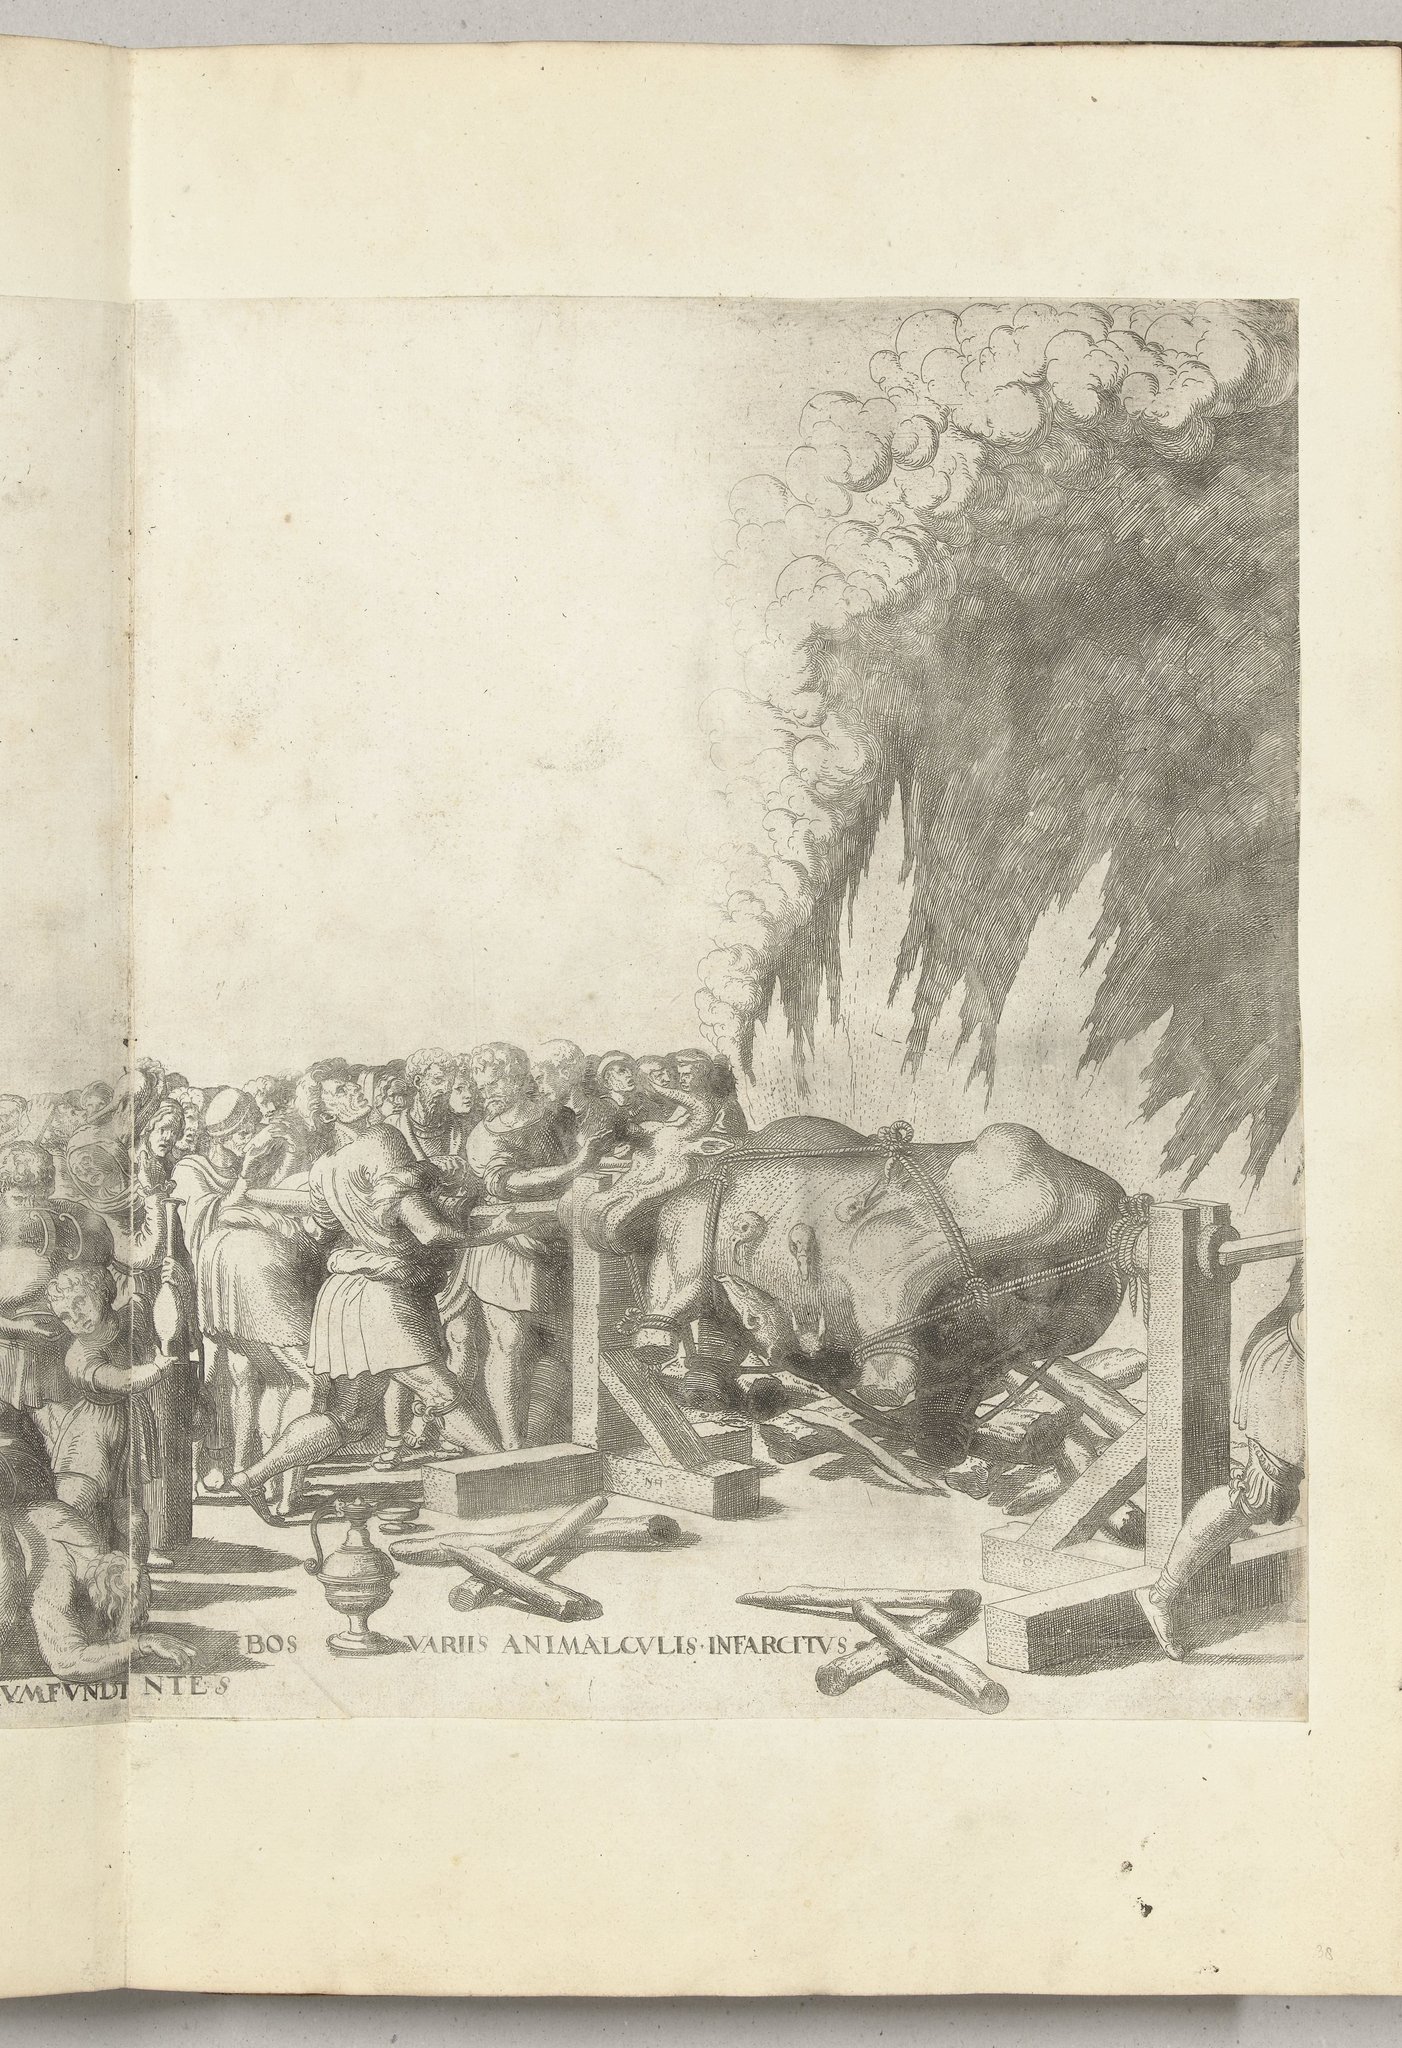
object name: propagandaprent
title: Optocht van Karel V met de paus te Bologna na zijn kroning to keizer, 1530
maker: nicolaas hogenberg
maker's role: draughtsman, painter, print maker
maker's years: 1500-1539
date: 1530-1536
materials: paper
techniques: etching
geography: mechelen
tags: ghent, charles v (holy roman emperor and king of spain), rome, festivities (+ parade, pageant, cavalcade ~ festive activities)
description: Prent in het album waarin zijn ingeplakt de 40 platen die achterelkaar samen het fries vormen van de optocht van Karel V met de paus Clemens VII te Bologna na zijn kroning tot keizer, 24 februari 1530.